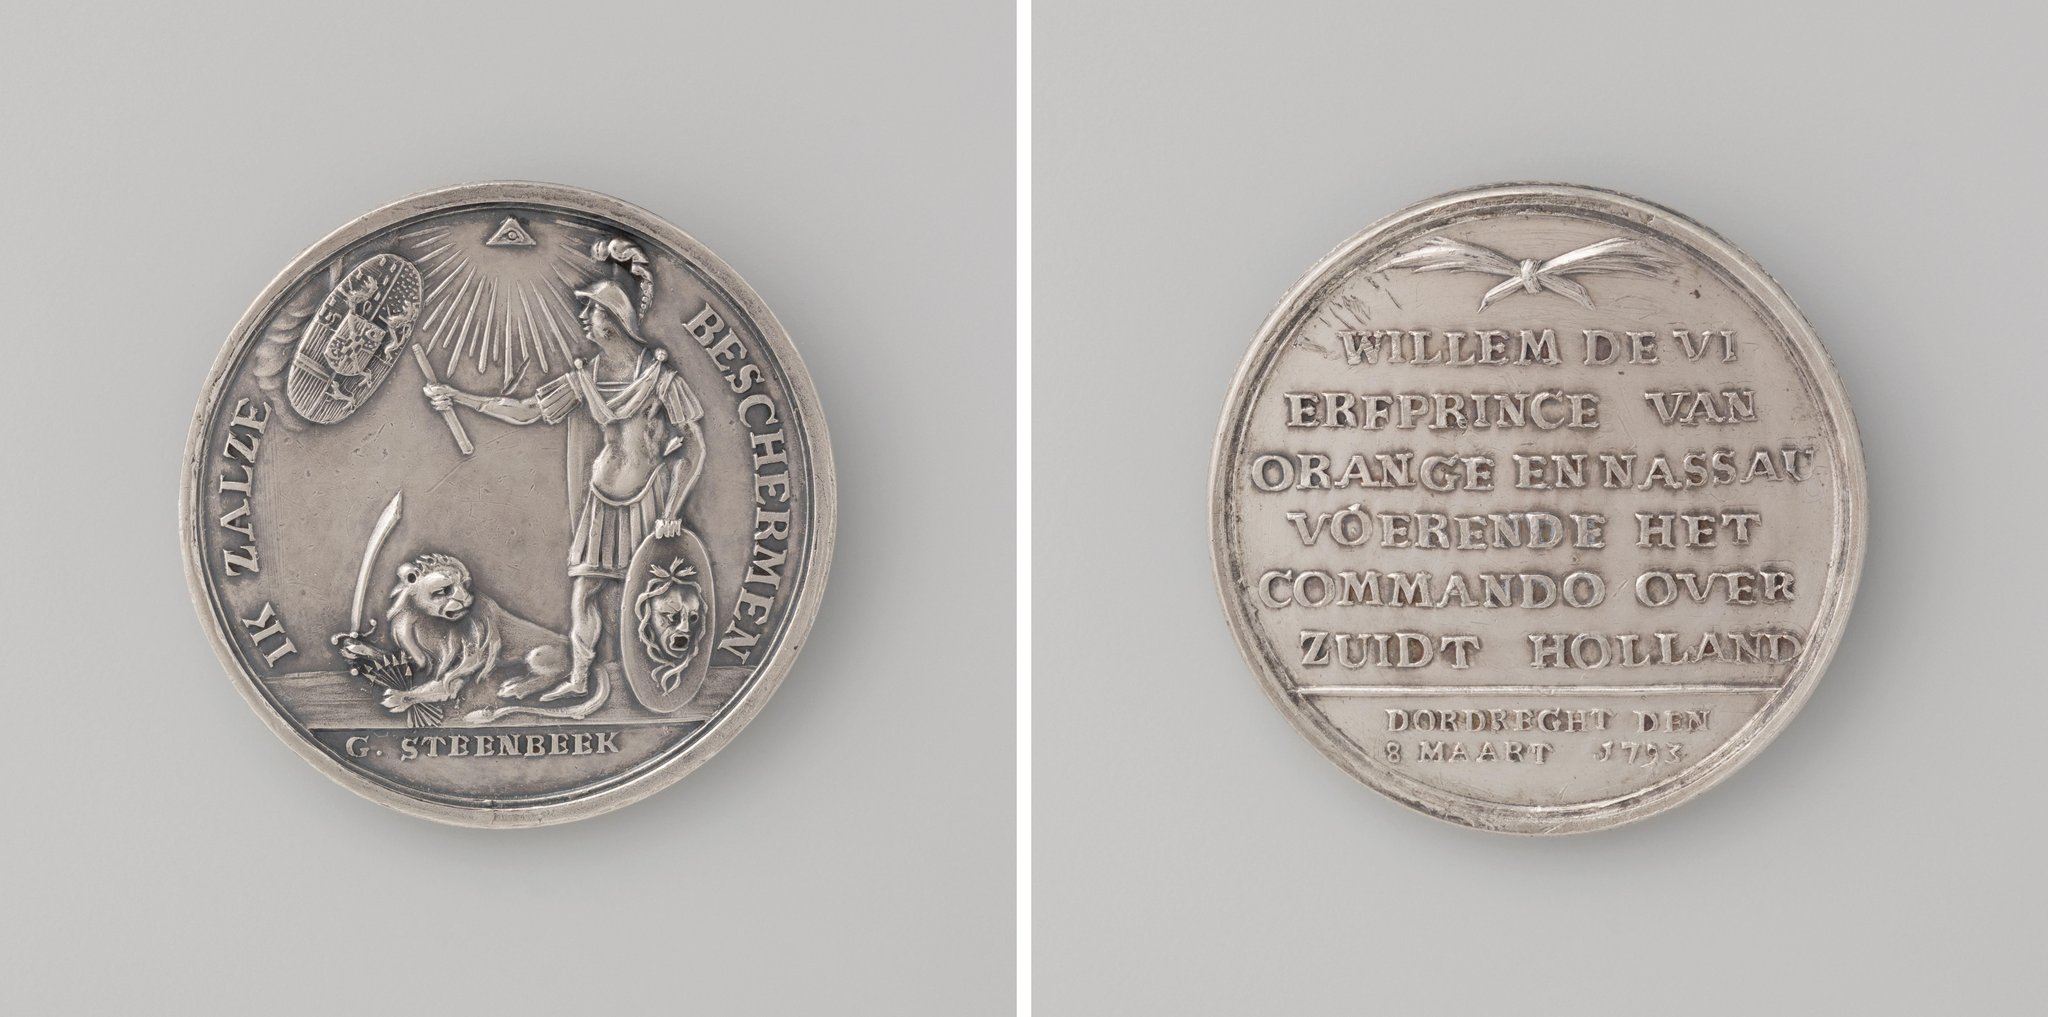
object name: history medal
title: Willem VI, erfprins van Oranje-Nassau aanvaardt het commando over Zuid-Holland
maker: gerrit steenbeek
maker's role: medailleur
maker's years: 1766-1837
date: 1793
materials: silver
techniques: striking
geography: netherlands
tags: the hague, berlin, william i of the netherlands, dordrecht